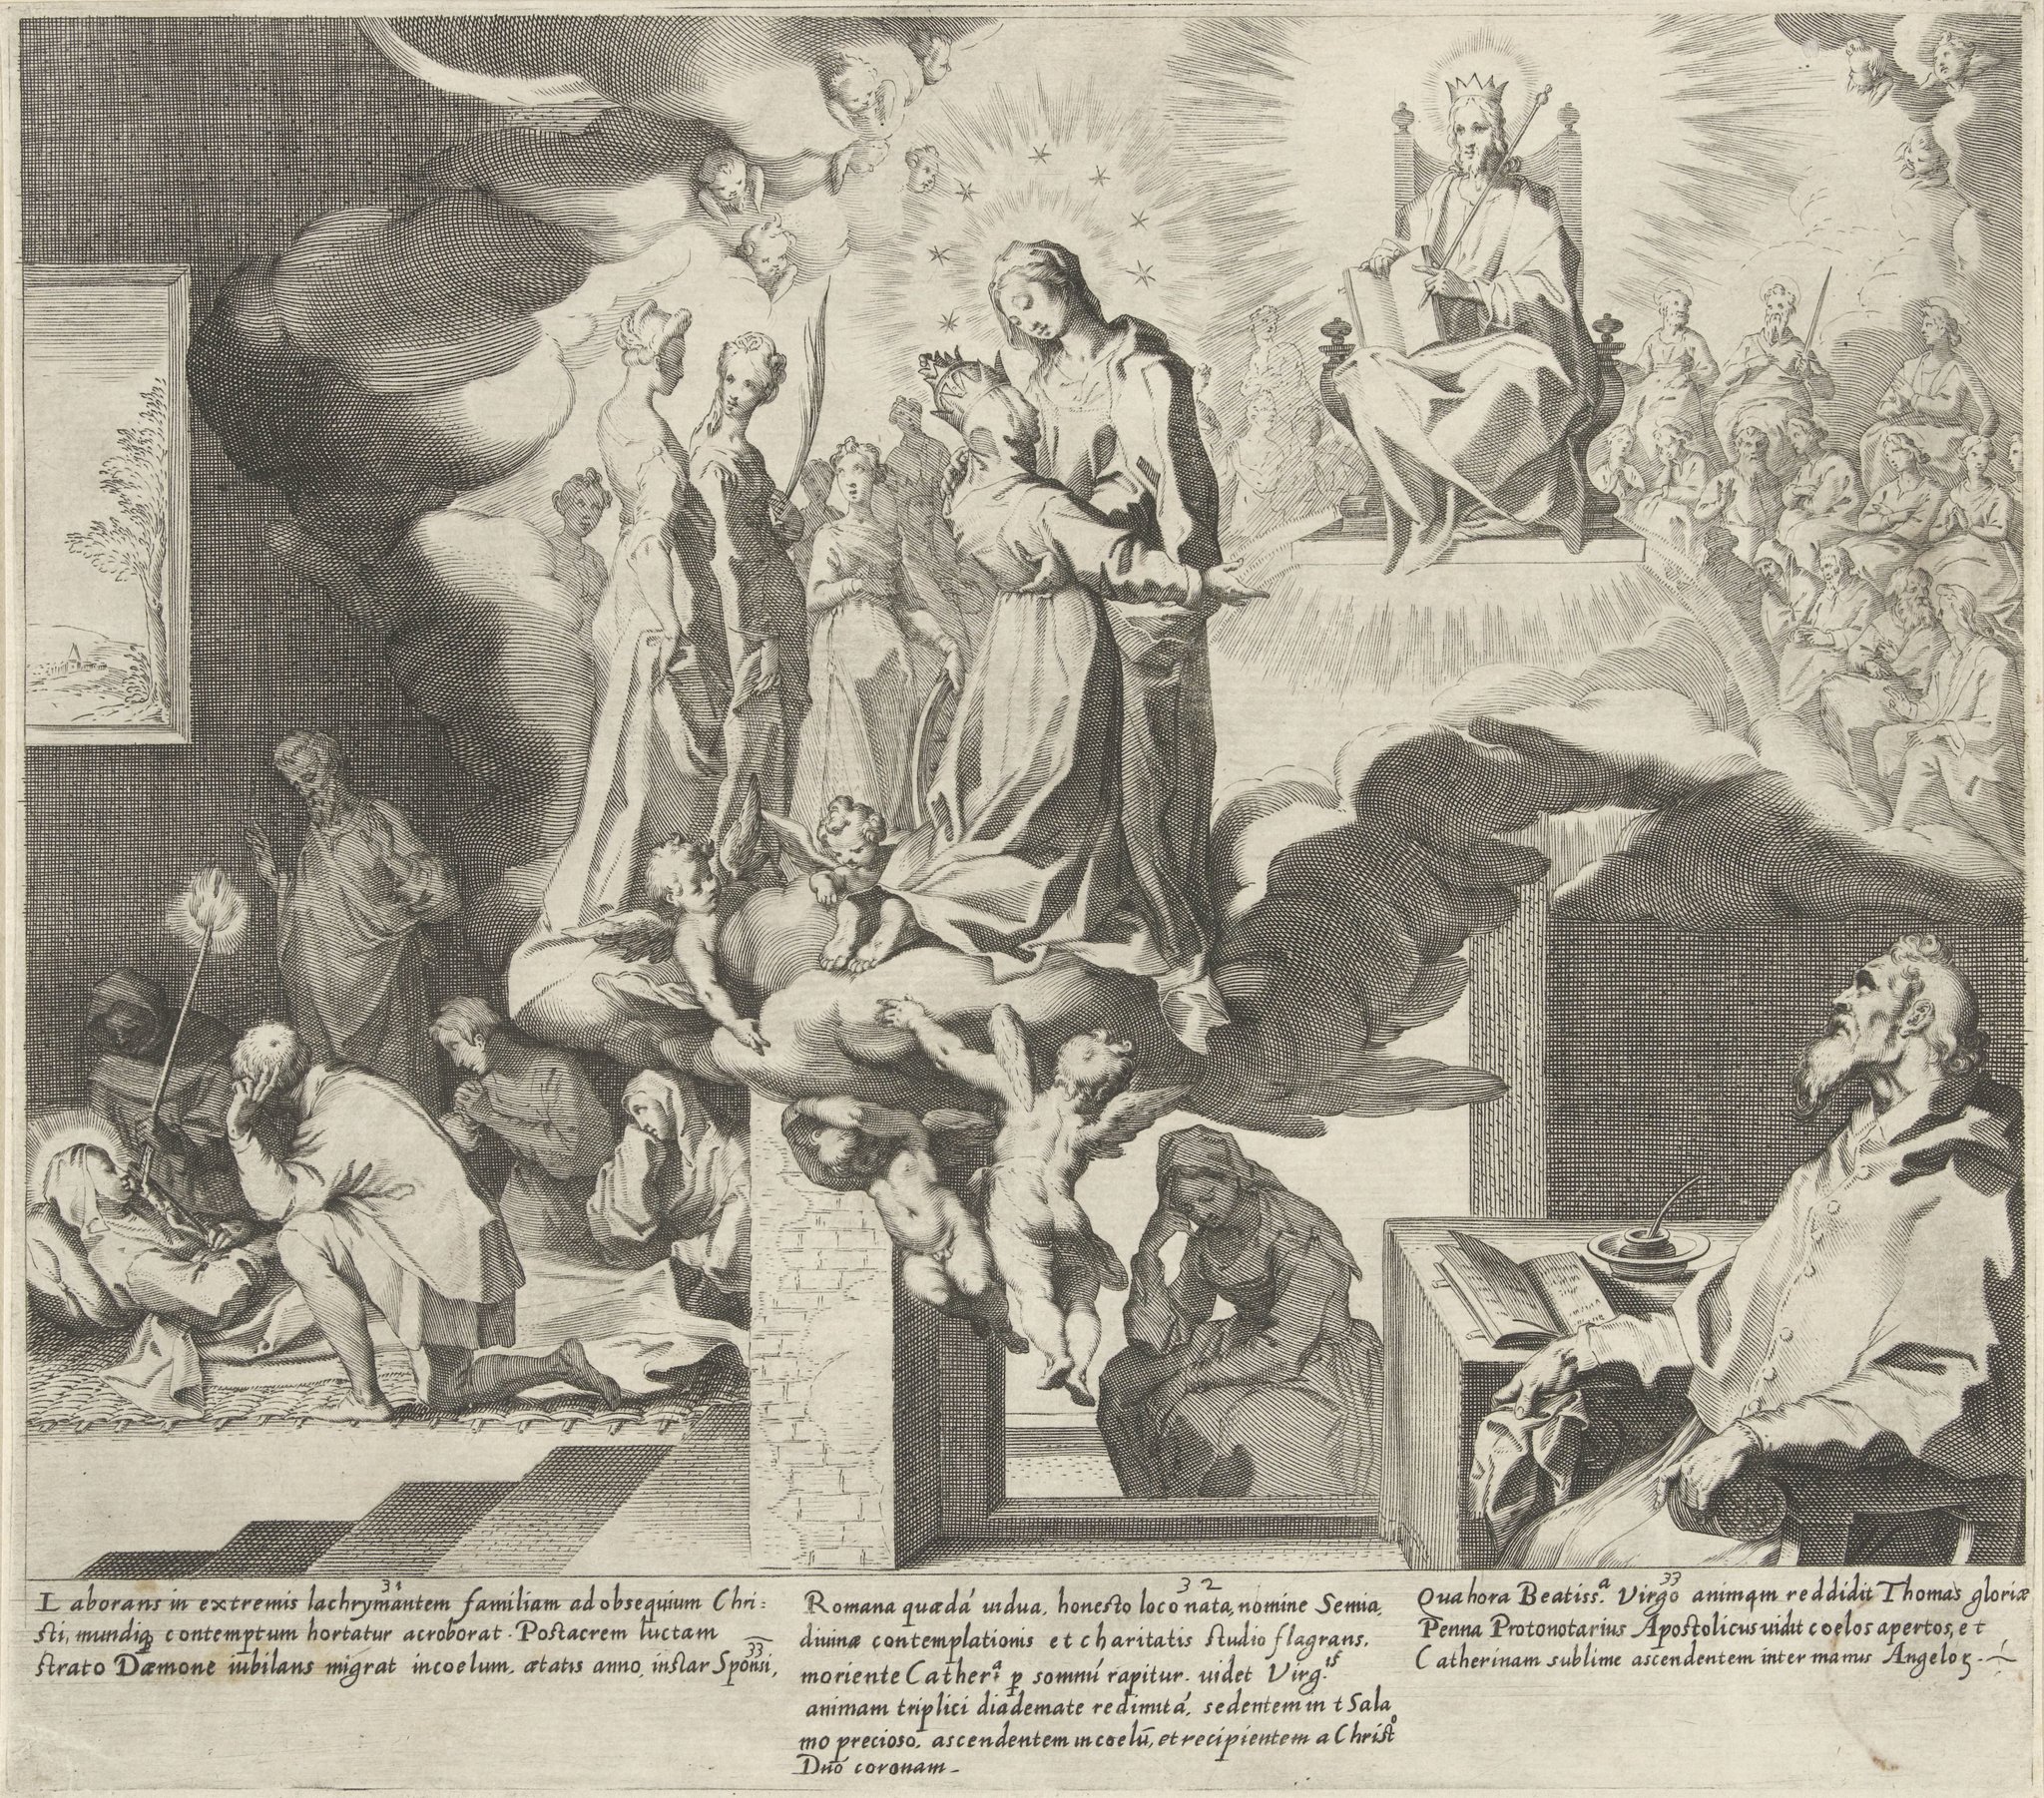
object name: print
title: Vita mors gesta, et miracula quaedam selecta B. CATHERINAE SENENSIS (...)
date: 1597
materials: paper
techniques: engraving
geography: italy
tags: the virgin and dominican tertiary, catherine of siena; possible attributes: book, cross, crown of thorns, crucifix, demon under foot, heart (with cross), lily, plague-stricken, ring, rosary, stigmata, the virgin and dominican tertiary, catherine of siena; possible attributes: book, cross, crown of thorns, crucifix, demon under foot, heart (with cross), lily, plague-stricken, ring, rosary, stigmata - death, deathbed of female saint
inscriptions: collector's mark: Lugt 240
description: Van links naar rechts: Catharina ligt op een matje op de grond. Ze wordt omringd door haar volgelingen en heeft een crucifix in haar armen. Thomas Penna (Protonotarius Apostolicus) is getuige van de tenhemelopneming van Catharina. Maria ontvangt haar in de hemel. Catharina knielt voor haar en draagt een hoge kroon. Rechts de tronende Christus. In de marge een toelichting op de voorstellingen in het Latijn. Twaalfde prent uit een serie van twaalf met het leven en de wonderen van de H. Catharina van Siena.